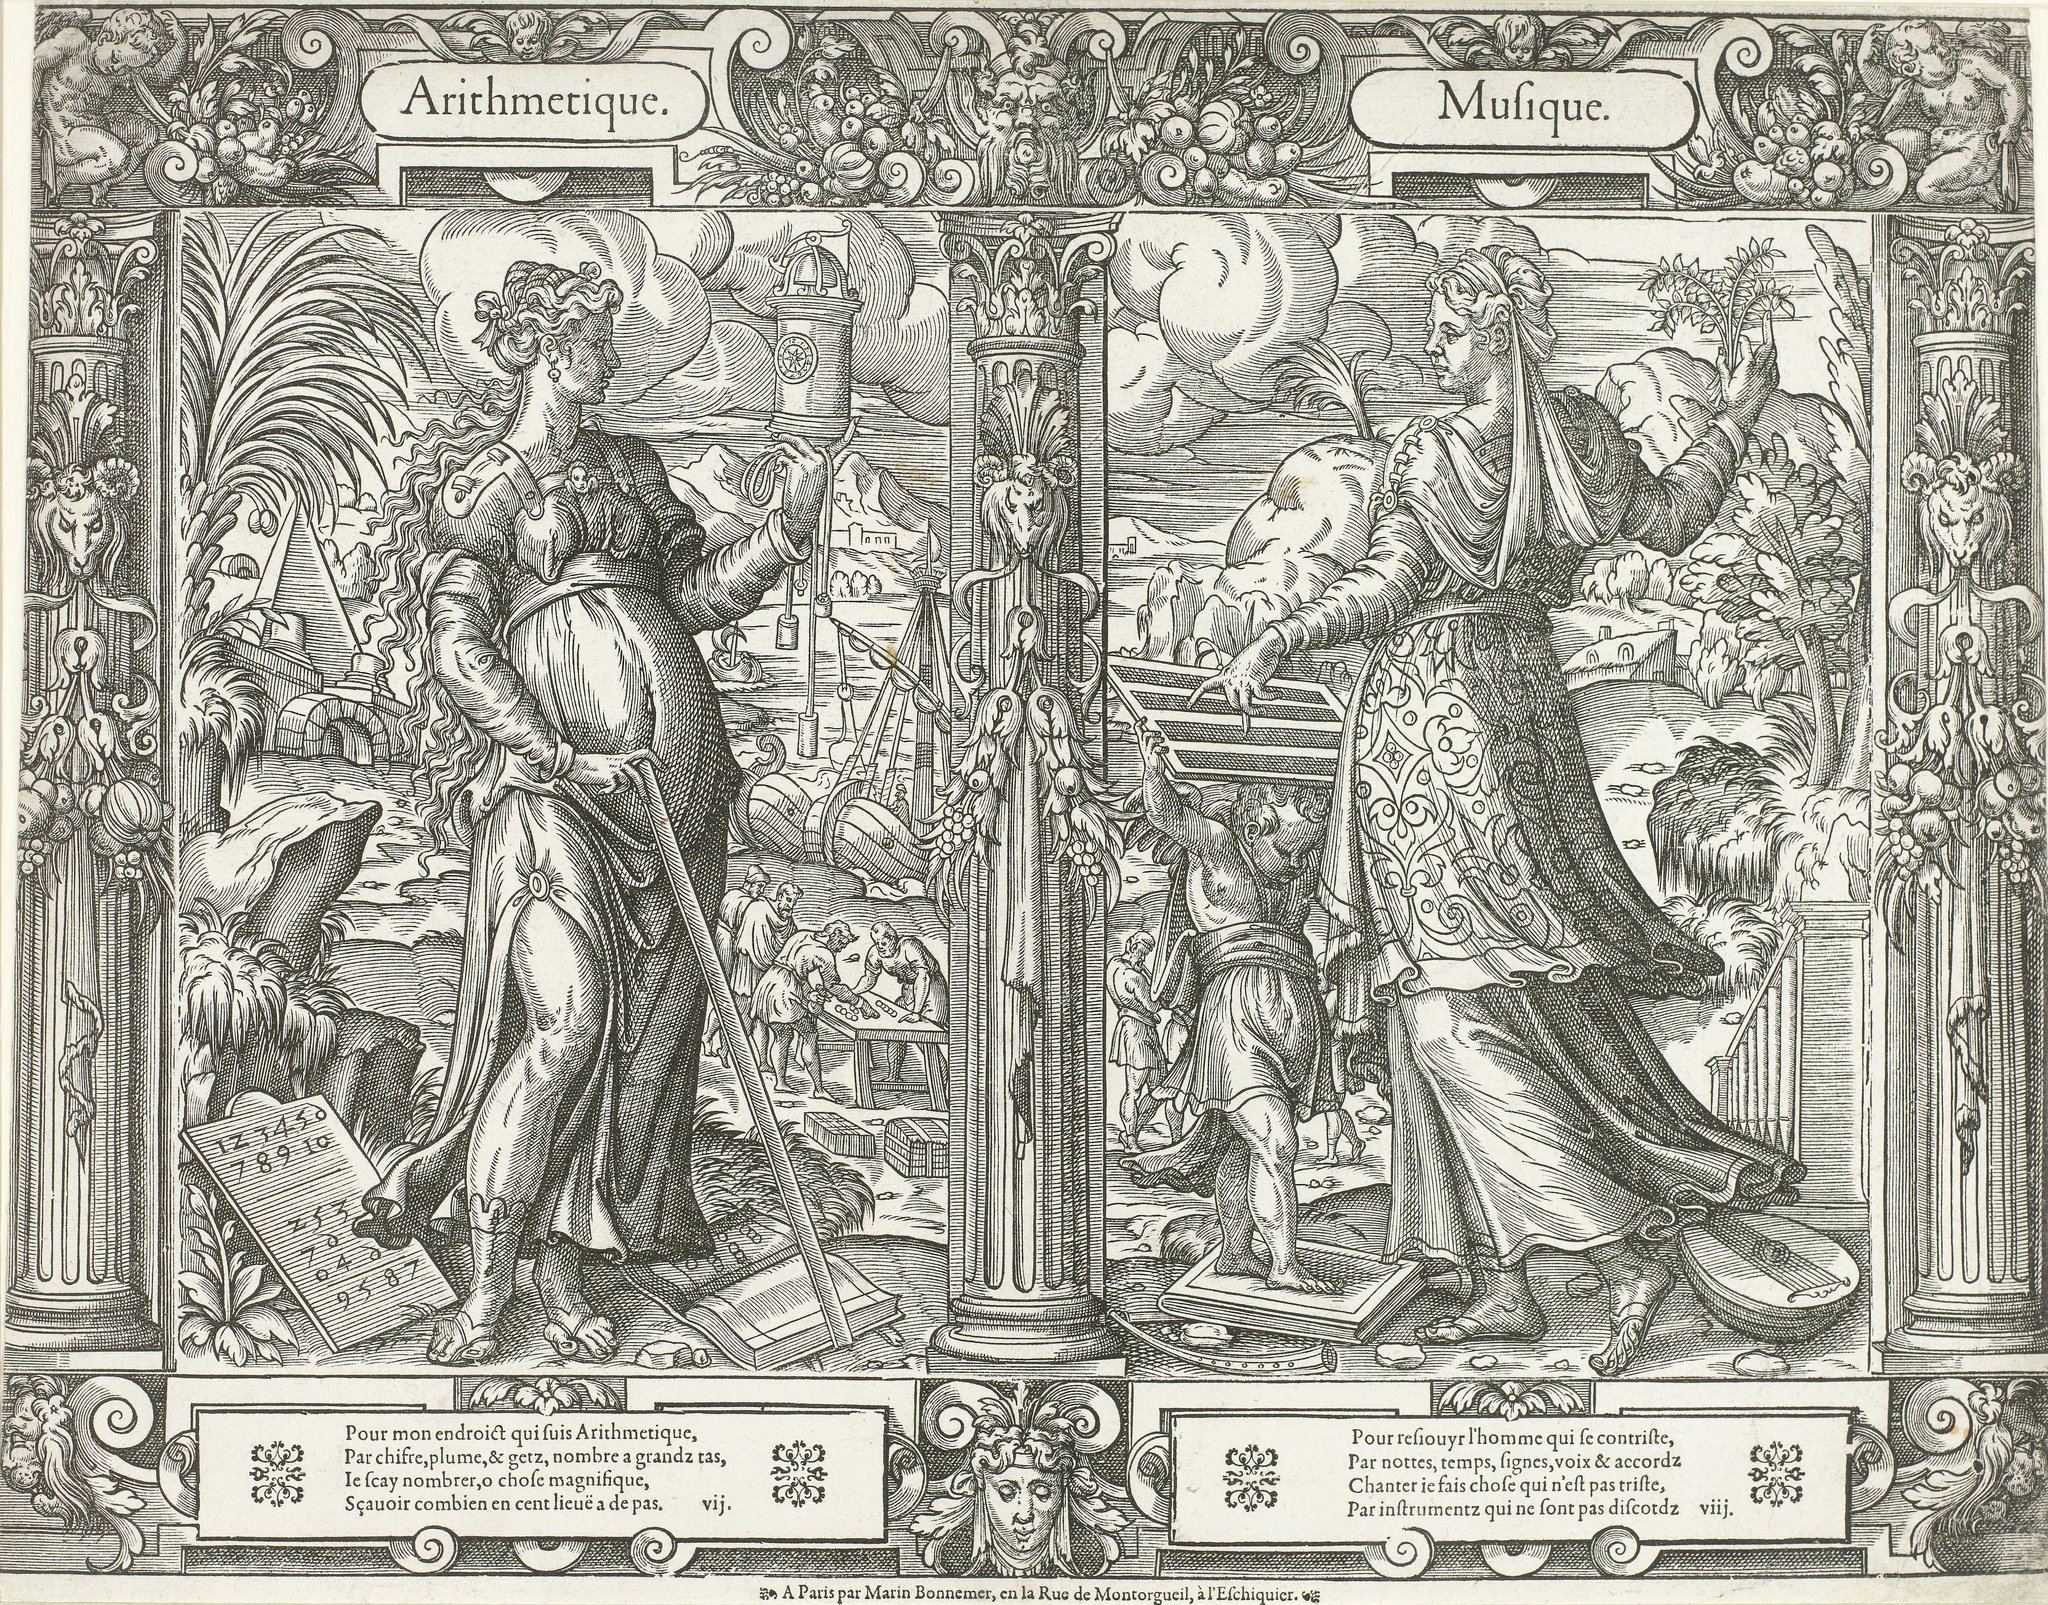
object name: print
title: Arithmetique Musique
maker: marin bonnemer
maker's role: print maker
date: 1563-1573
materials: paper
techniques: woodcut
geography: paris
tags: 'arithmetica' (~ quadrivium); 'aritmetica' (ripa), 'musica' (~ quadrivium); 'musica' (ripa)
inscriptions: collector's mark: Lugt 240, collector's mark: Lugt 2228